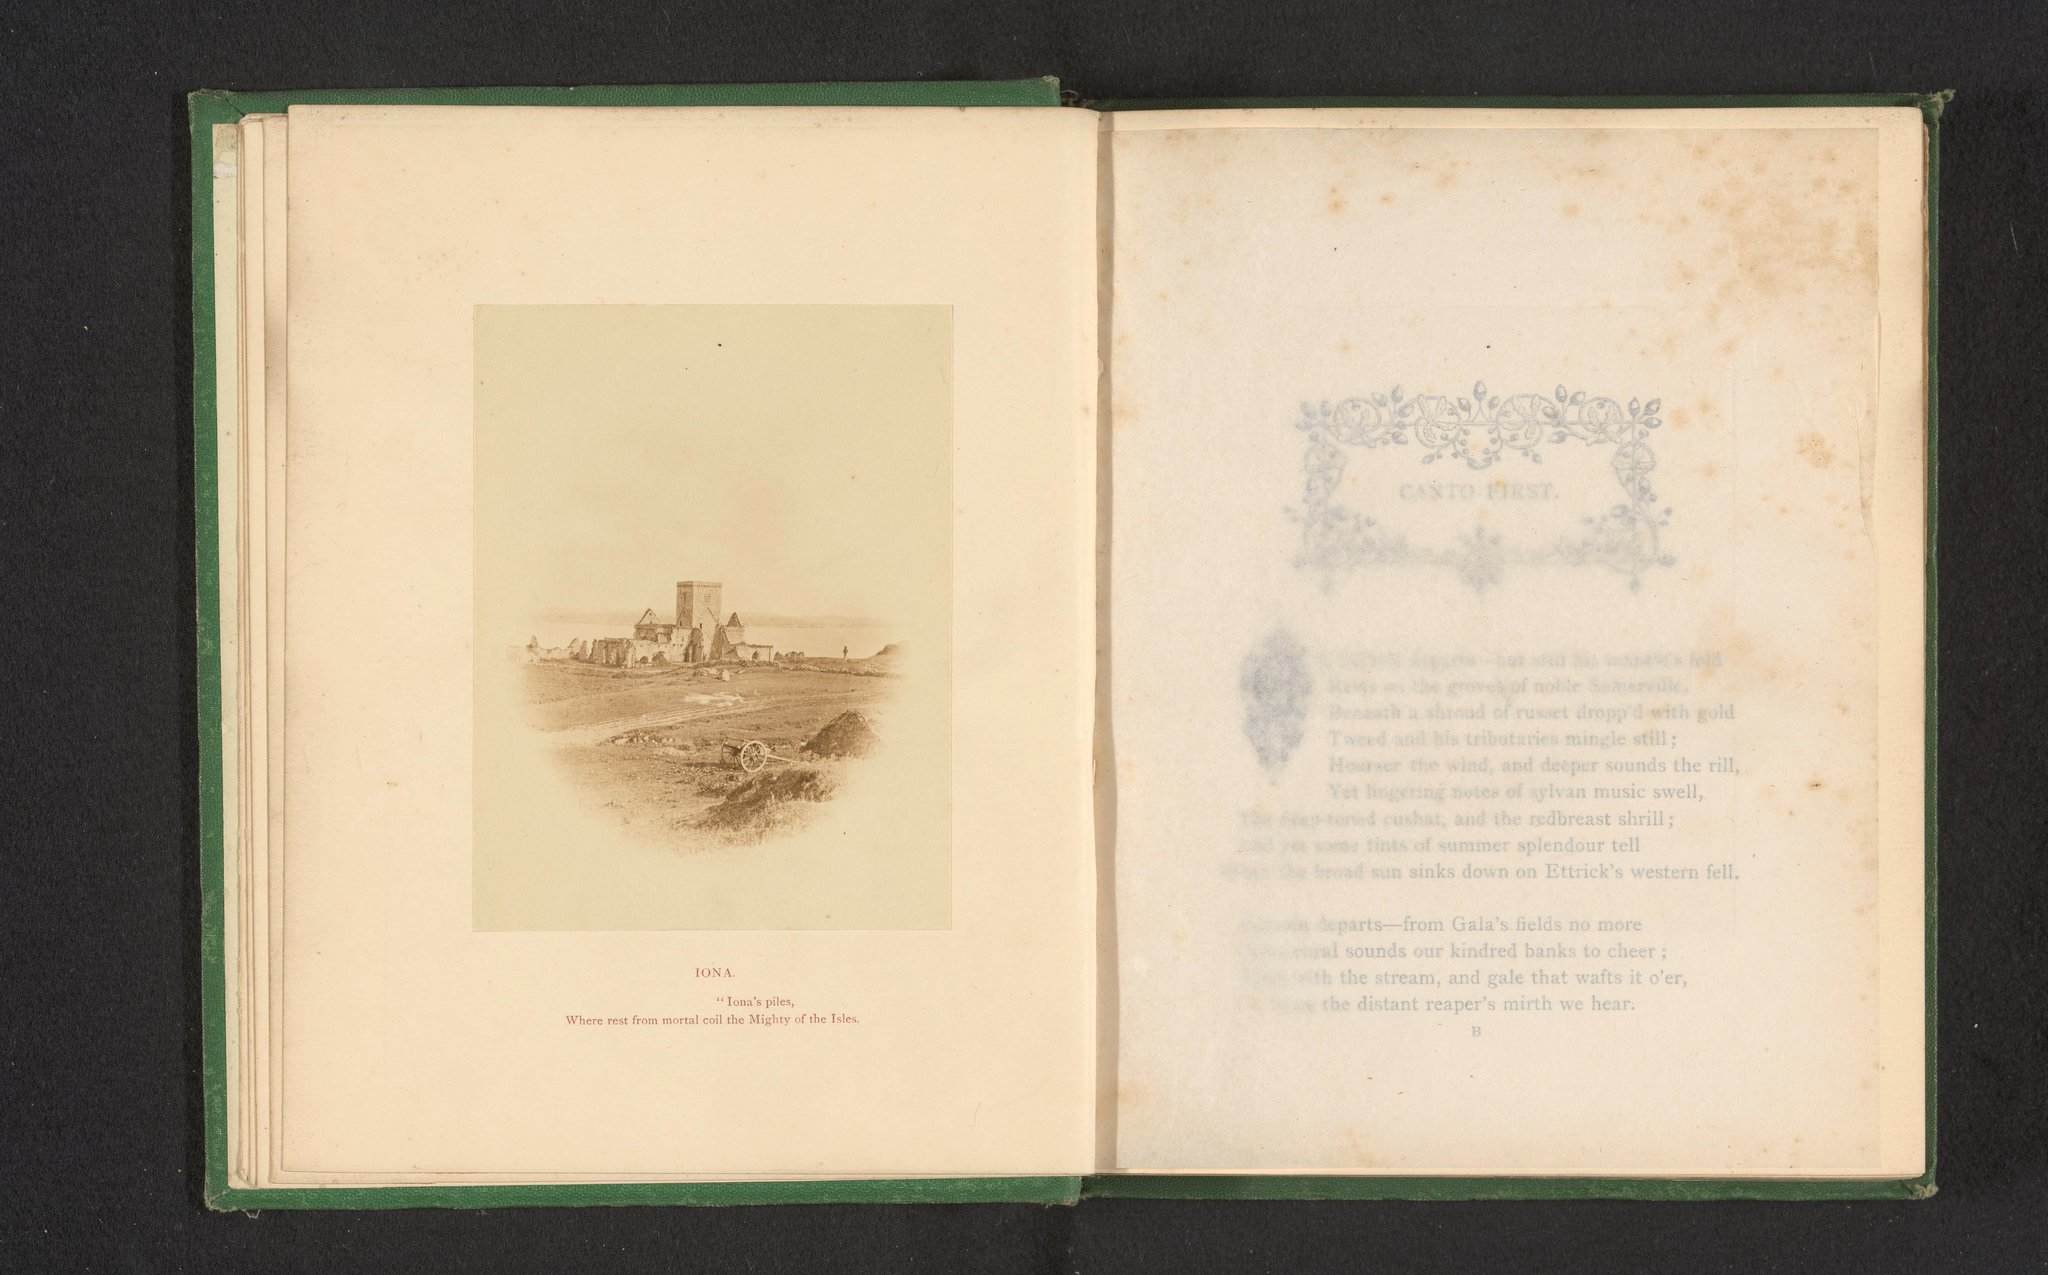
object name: photograph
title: Iona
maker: stephen thompson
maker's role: fotograaf, schrijver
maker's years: 1831-1893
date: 1861-1871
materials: photographic support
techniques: albumen print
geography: iona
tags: ruin of church, monastery, etc.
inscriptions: inscription: ‘"Iona's piles (...) of the Isles.’